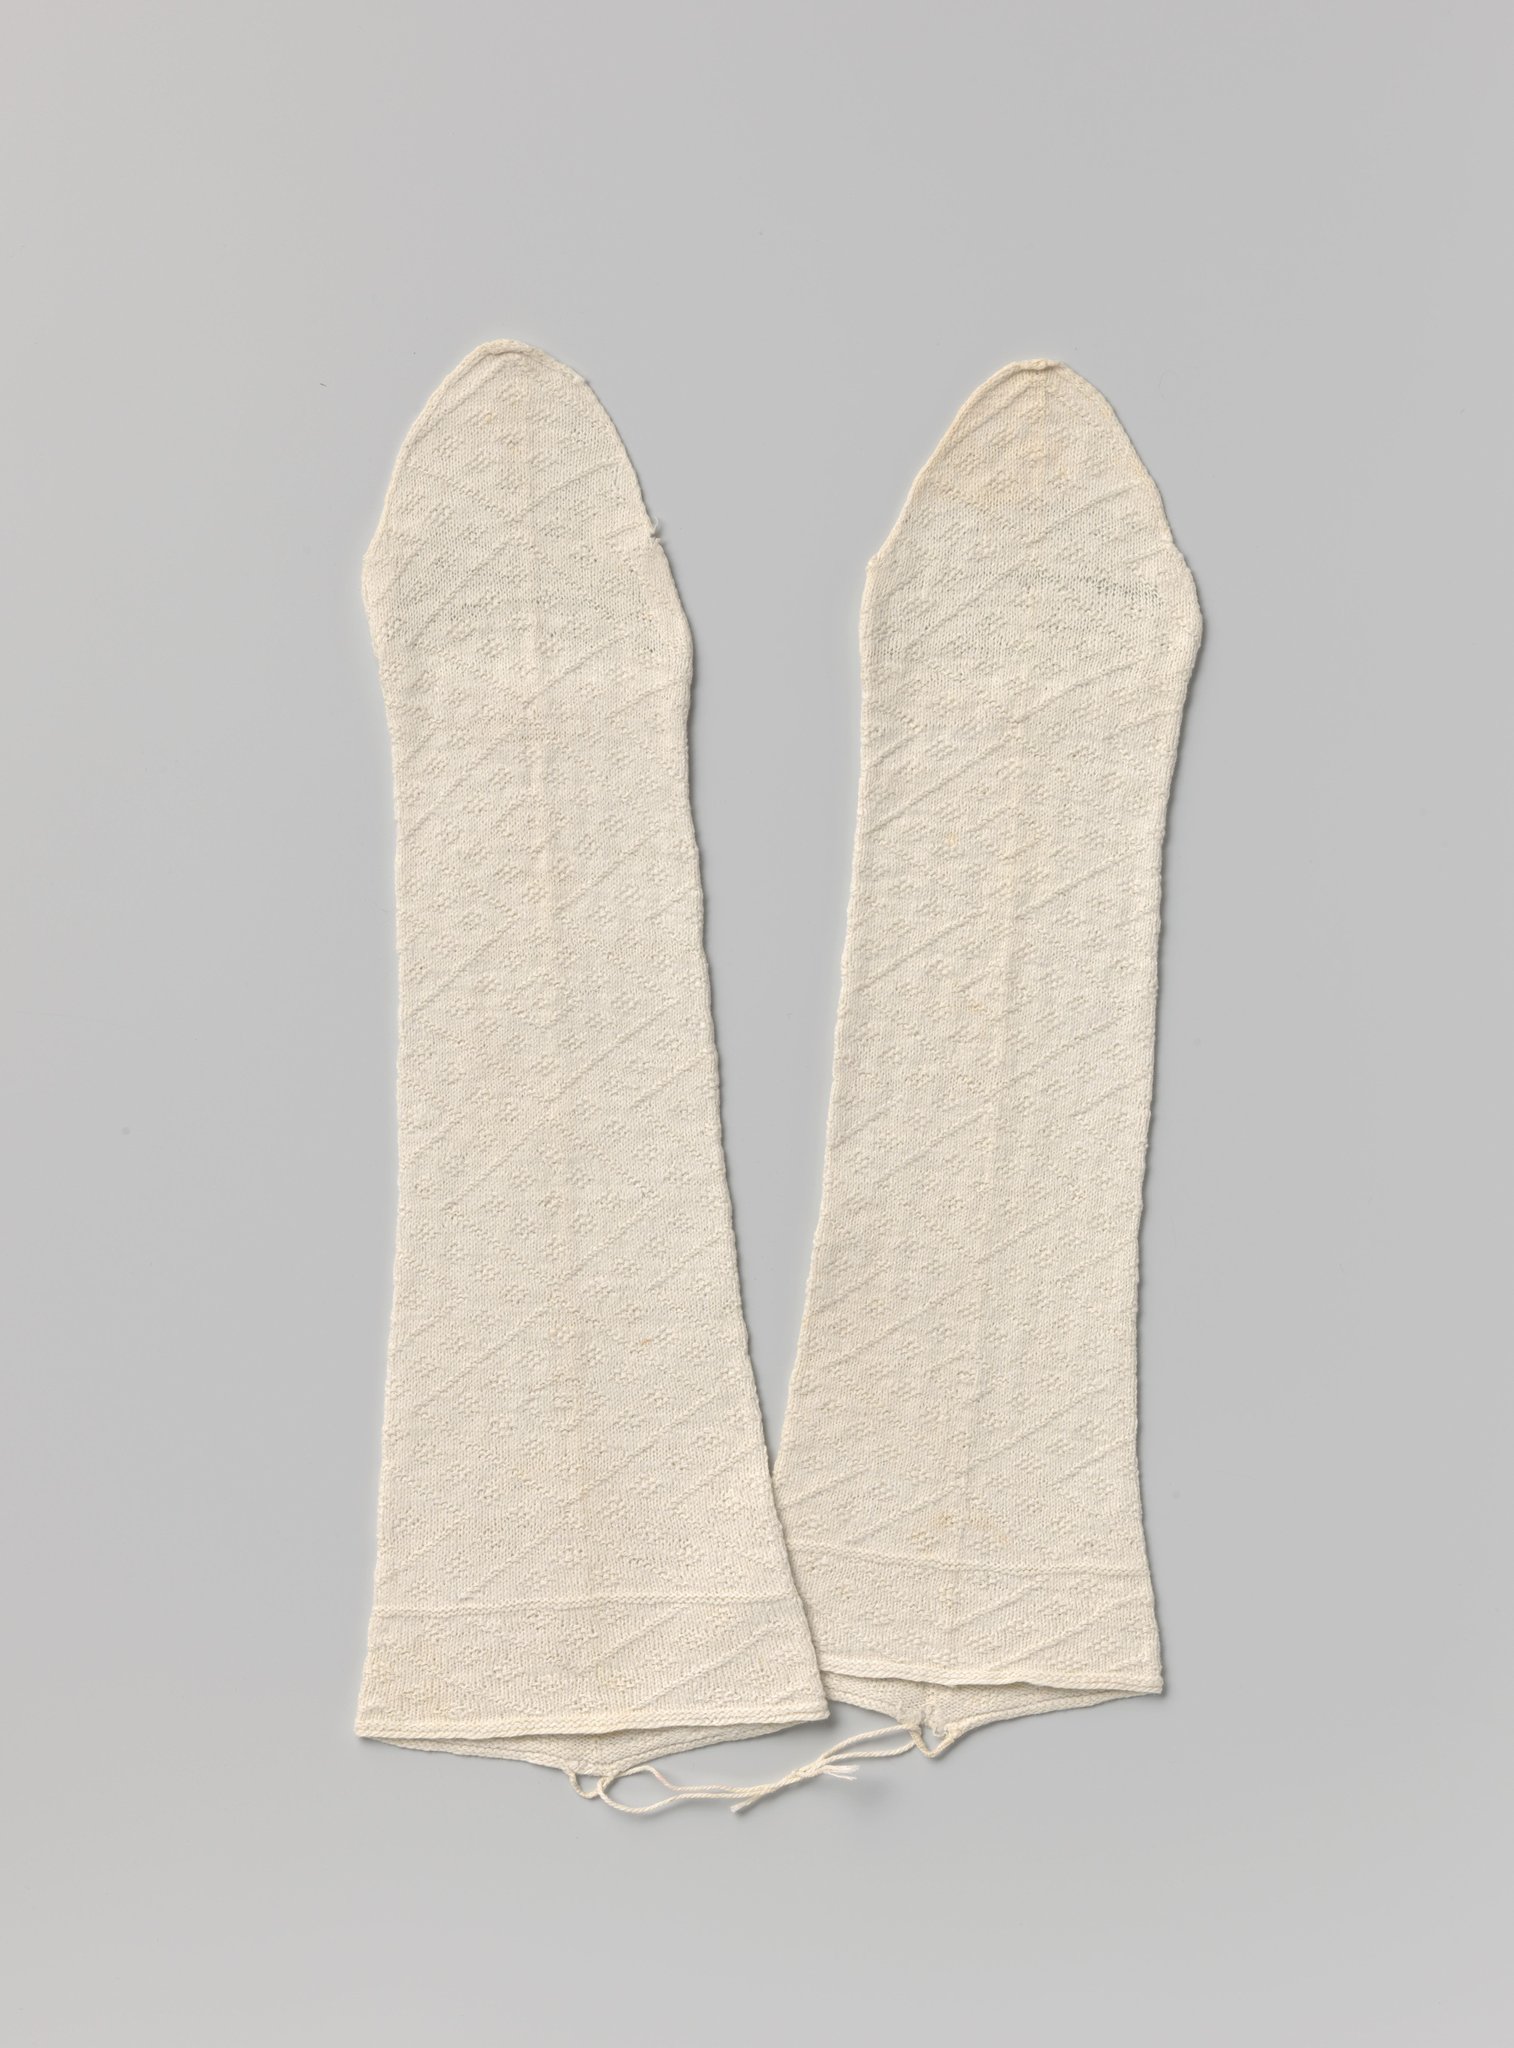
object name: clothing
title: Mitaine van witte gebreide katoen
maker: Anonymous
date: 1750-1800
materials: cotton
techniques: embroidered, knitting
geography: western europe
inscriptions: : ‘AEL / G of 6’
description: Mitaine van witte gebreide katoen, met een patroon van dunne heen en weer gaande en blokjes. Onderaan onversierd. Gemerkt in bruin: AEL / G of 6